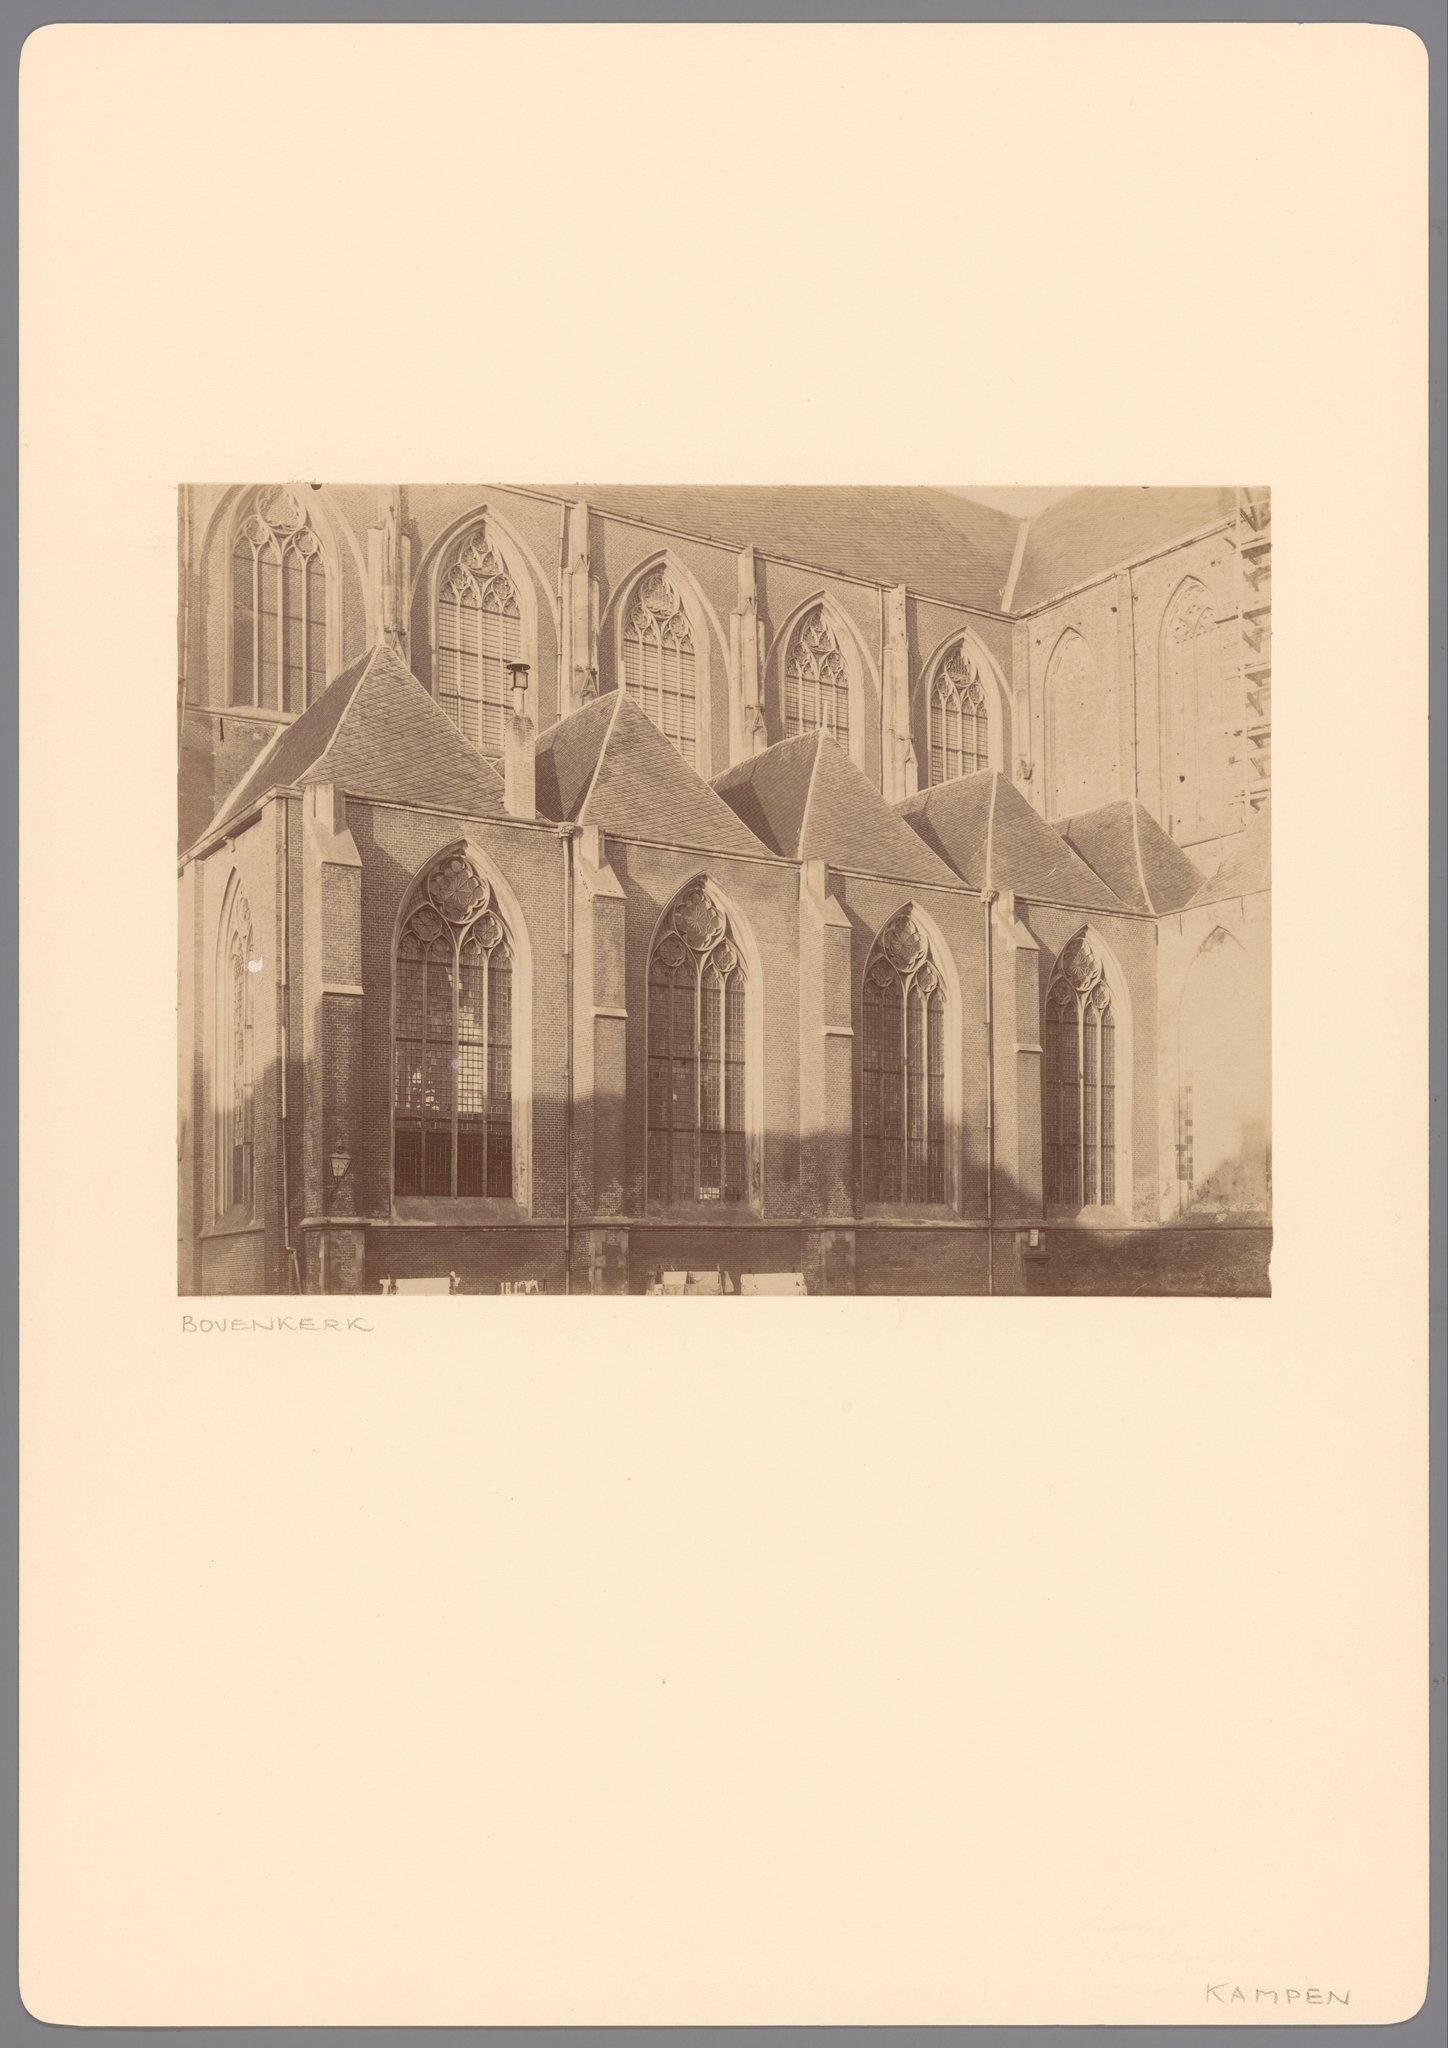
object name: photograph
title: Zijaanzicht van de Bovenkerk te Kampen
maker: anoniem (monumentenzorg)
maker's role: fotograaf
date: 1891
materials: cardboard, photographic support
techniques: albumen print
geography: kampen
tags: church (exterior)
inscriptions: annotation: ‘Kampen/ Bovenkerk/ zijaanzicht/ oct 1891’, annotation: ‘Bovenkerk/ Kampen’